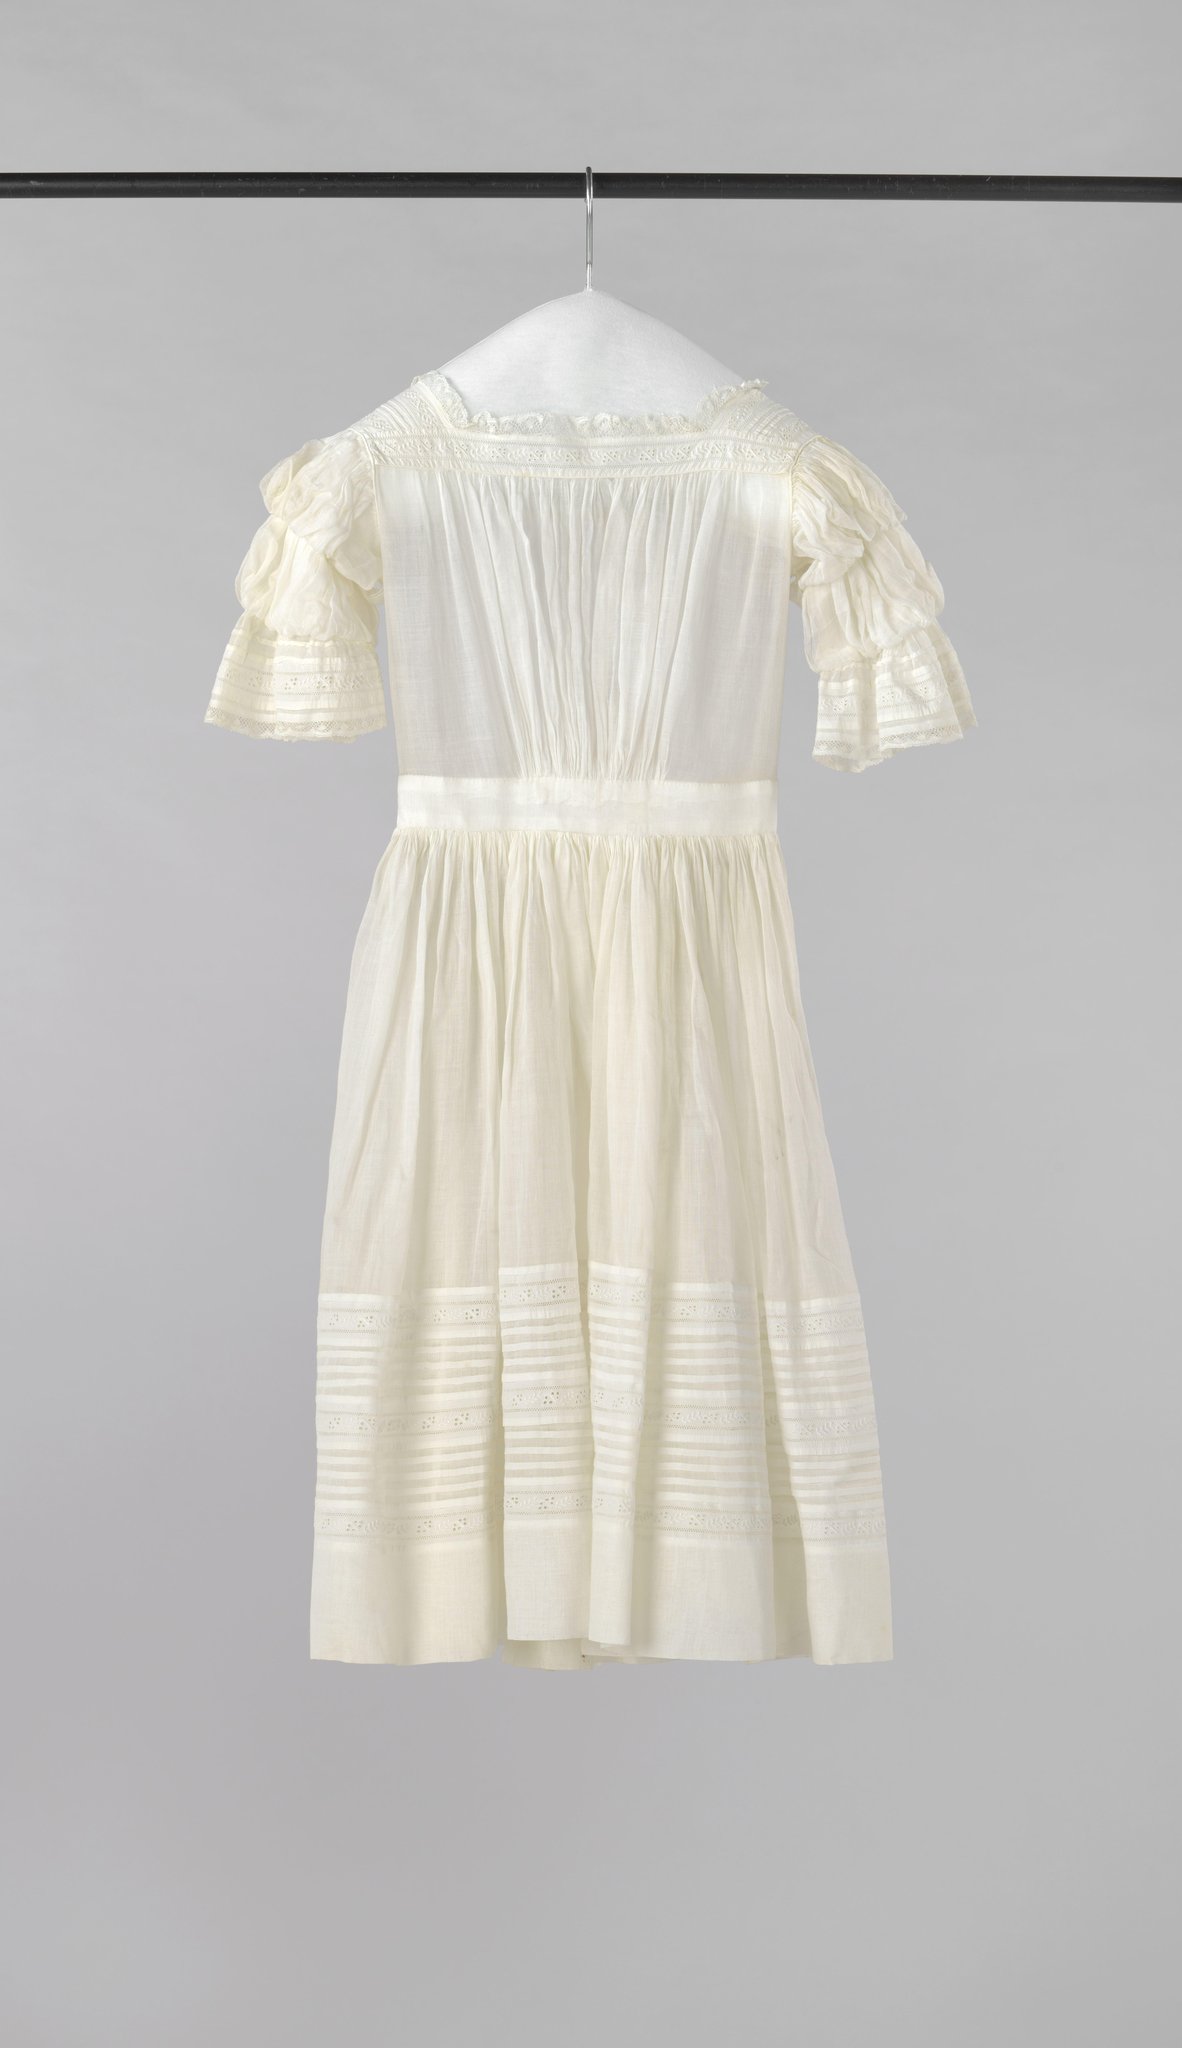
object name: main garment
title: Jurk met korte mouw, brede tailleband en achtersluiting met twee parelmoeren knopen van doorzichtig geweven wit katoen, versierd met oprijgen, Engels borduurwerk en kant.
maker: Anonymous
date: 1880-1920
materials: cotton, mother of pearl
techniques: embroidered